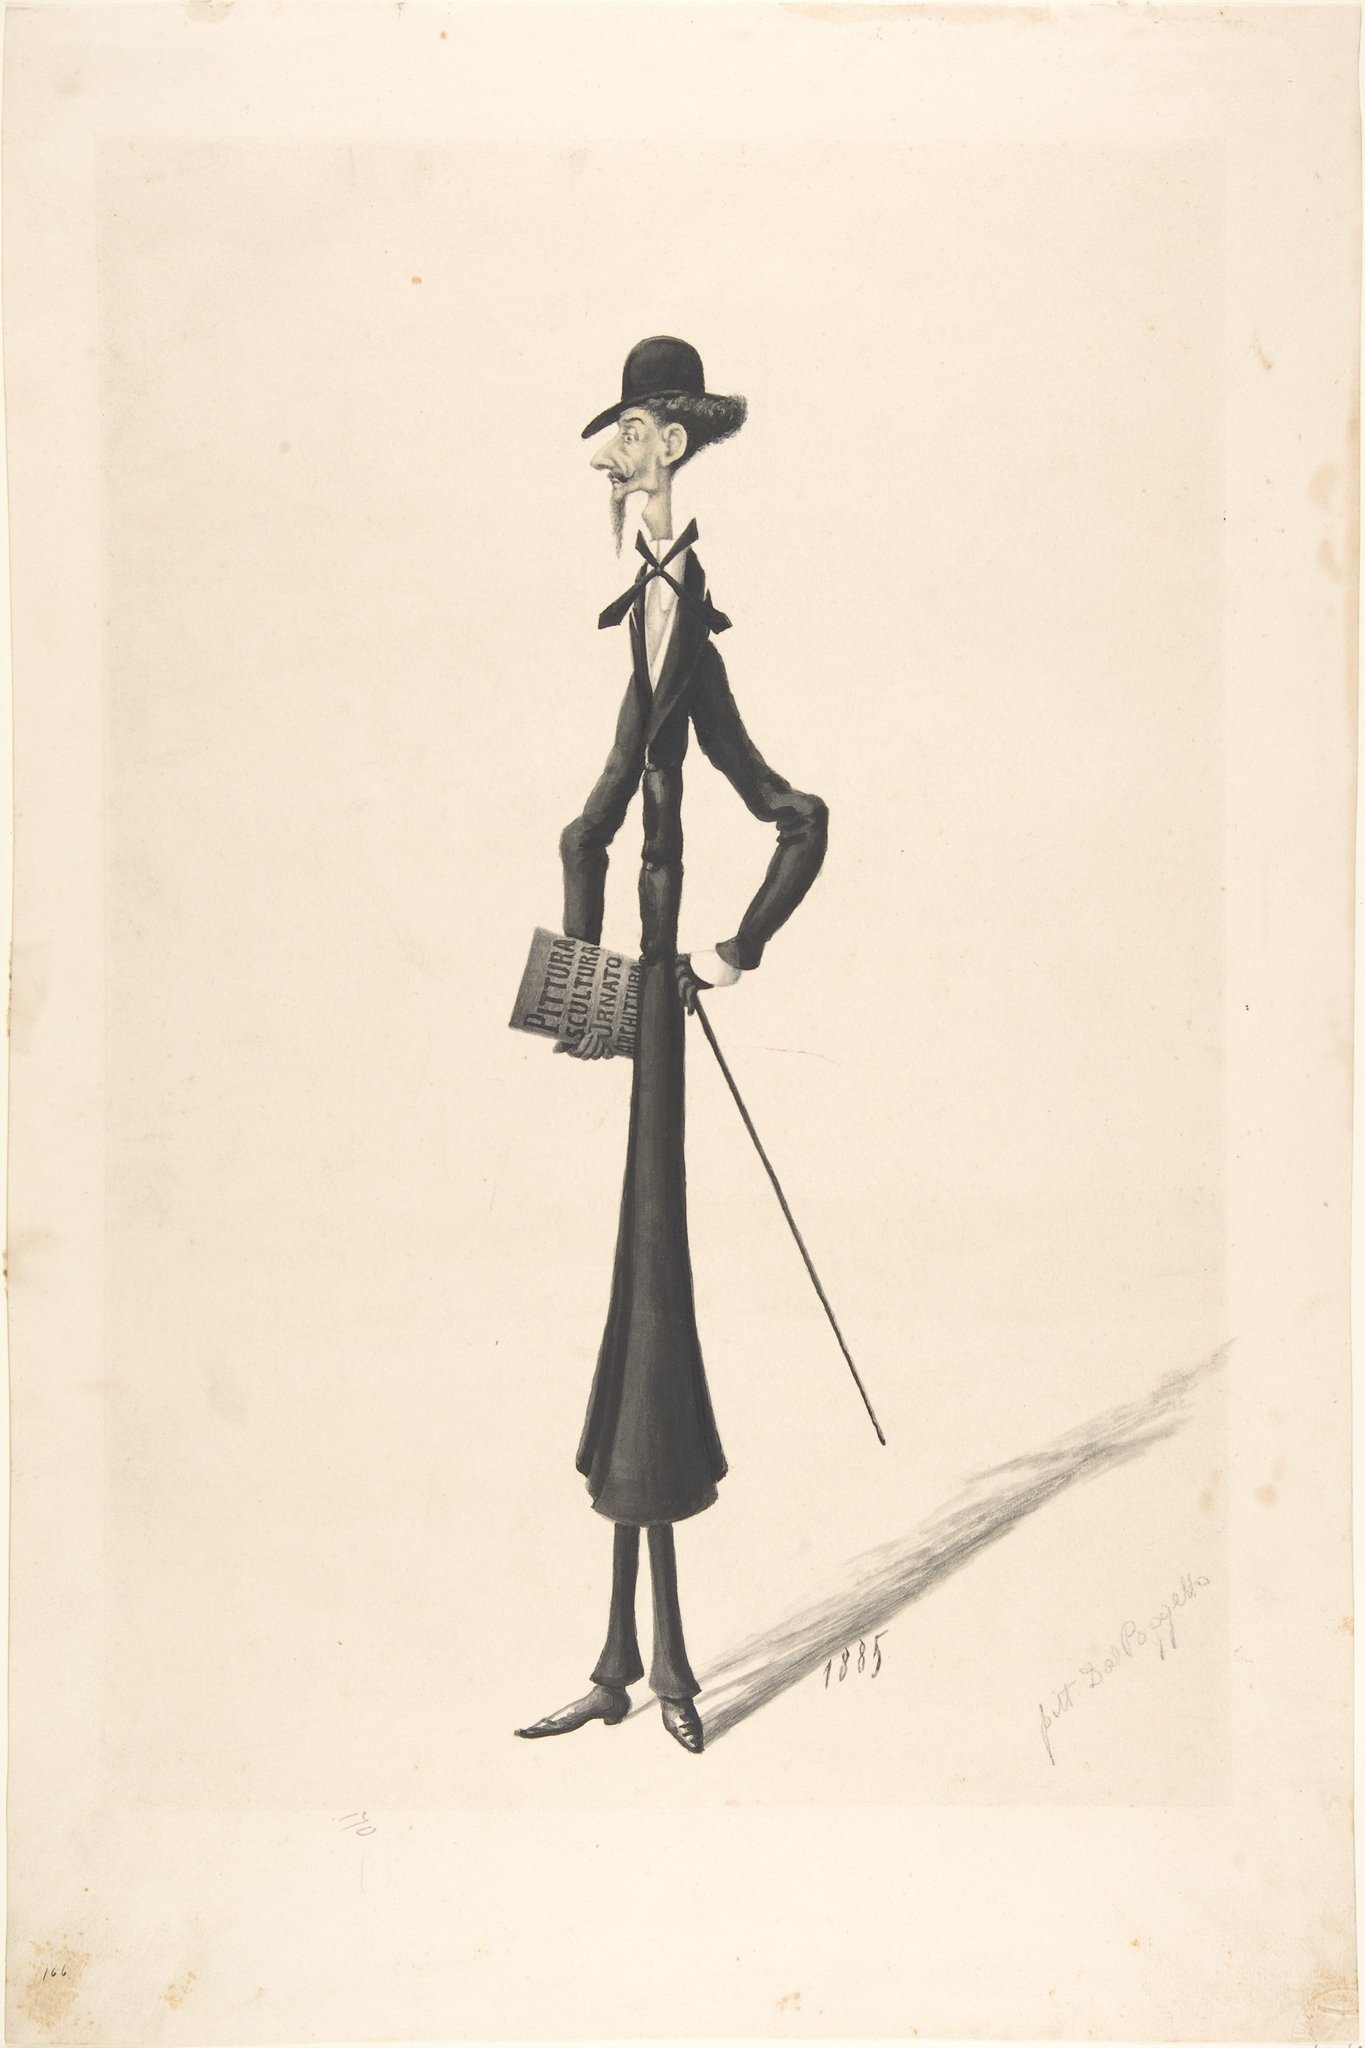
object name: drawing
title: Caricature of a Tall Thin Man Carrying a Book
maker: anonymous, italian, 19th century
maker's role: artist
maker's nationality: italian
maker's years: 1800-1900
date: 1885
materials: watercolor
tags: books,men,profiles